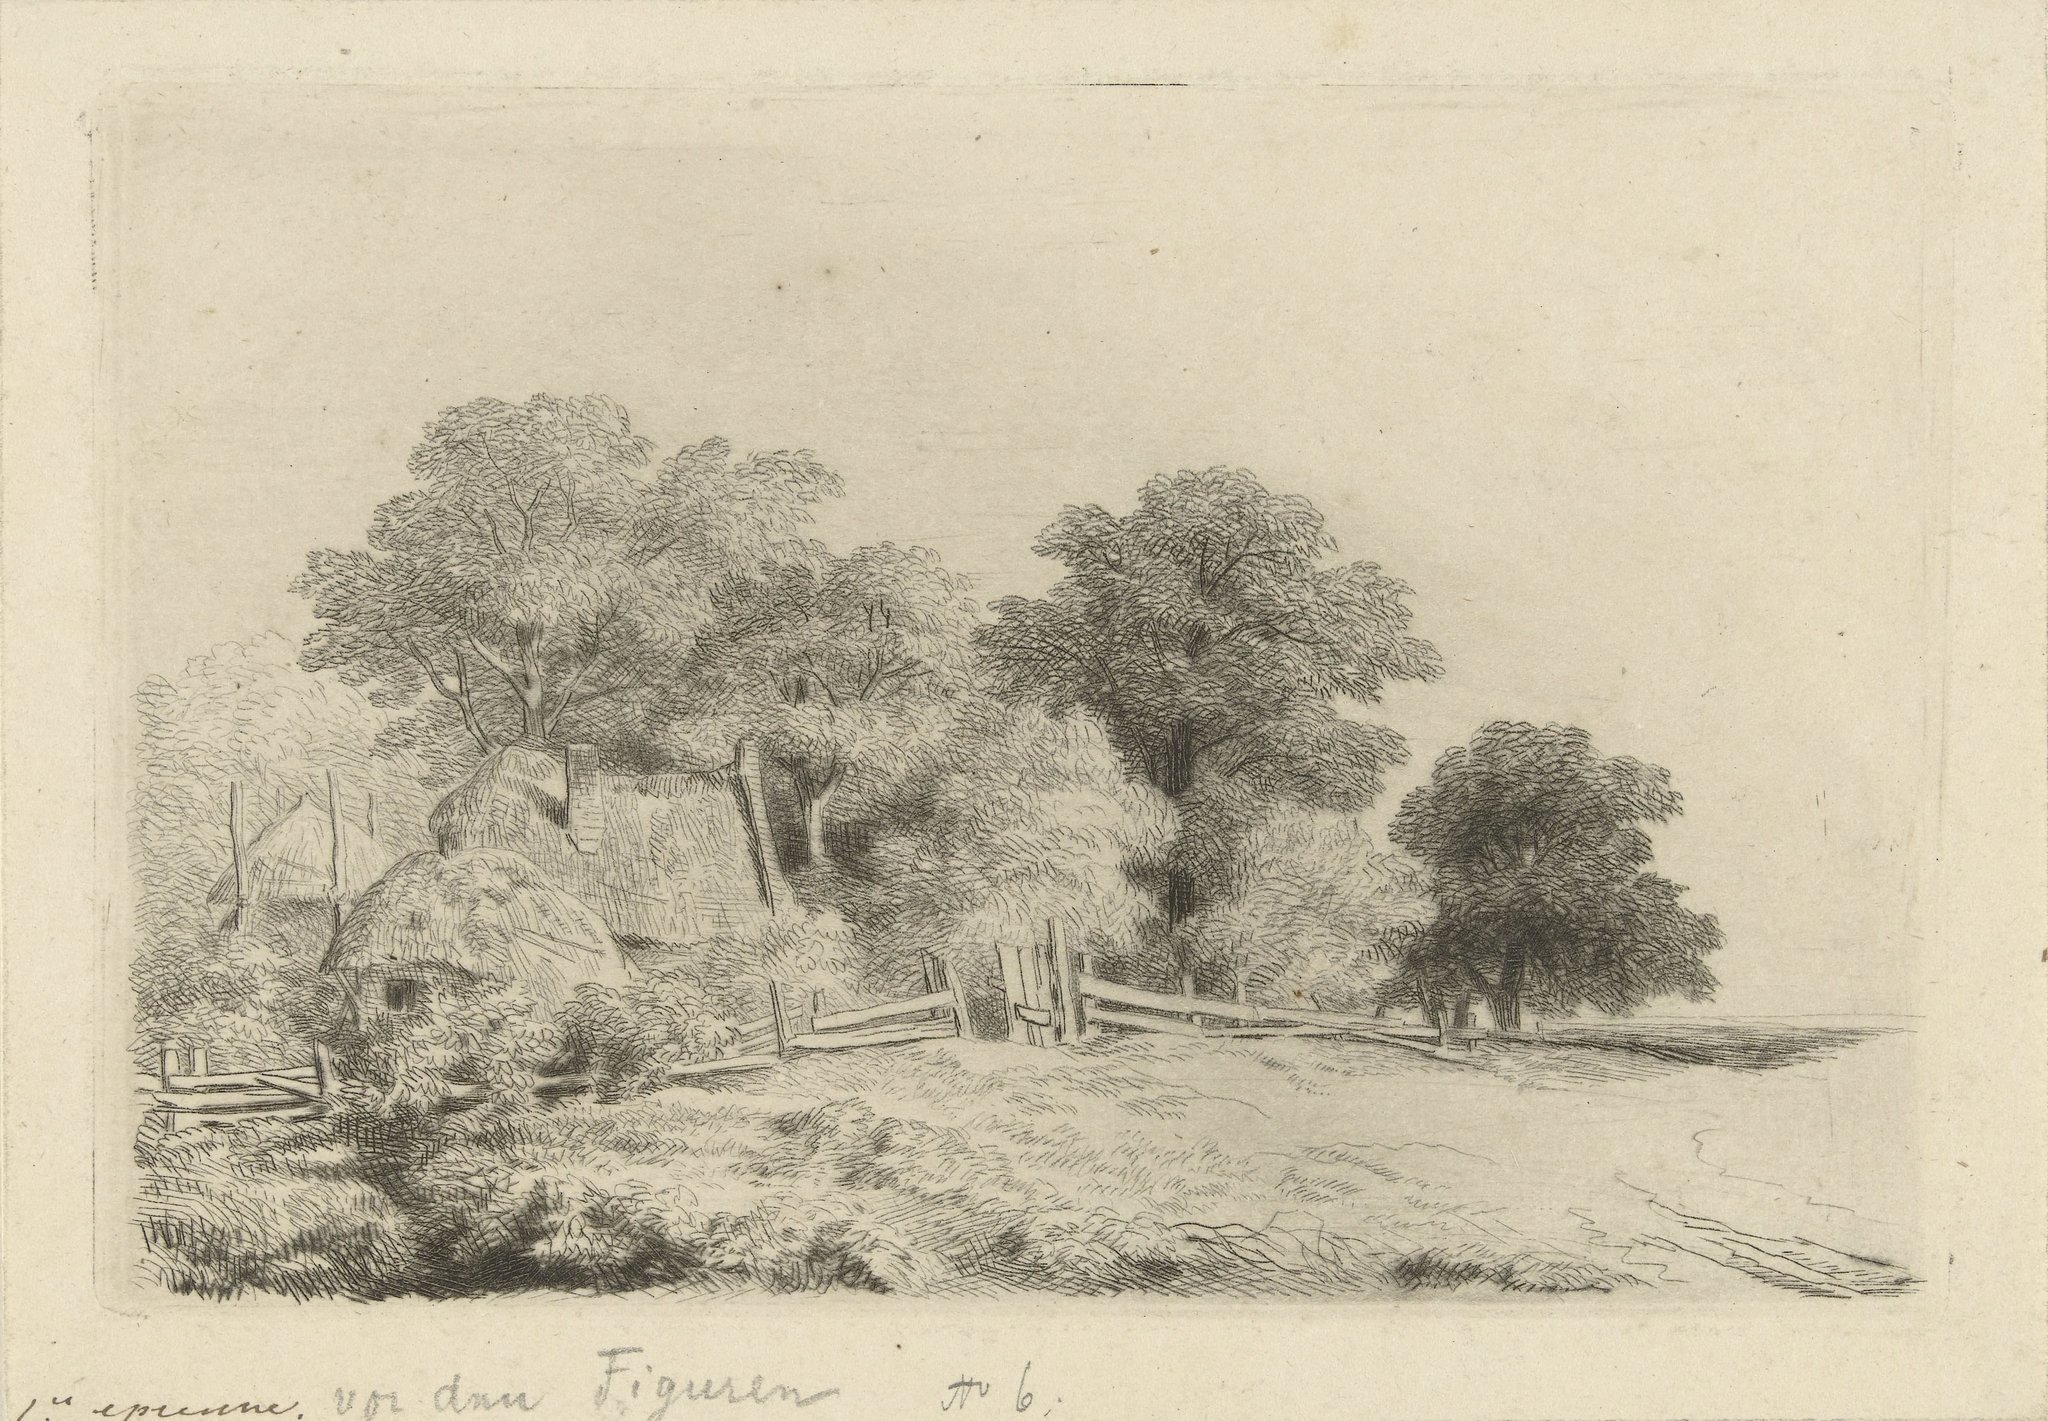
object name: print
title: Boerderij bij een hek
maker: remigius adrianus haanen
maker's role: draughtsman, painter, print maker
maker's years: 1812-1894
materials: paper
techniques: drypoint, etching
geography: austria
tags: farm or solitary house in landscape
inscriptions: annotation: ‘vor den figuren No. 6;’, annotation: ‘1e. epreuve’, collector's mark: Lugt 2228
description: Een landschap met een boerderij, een schuur en een hooiberg achter een hek bij een bomenrij.